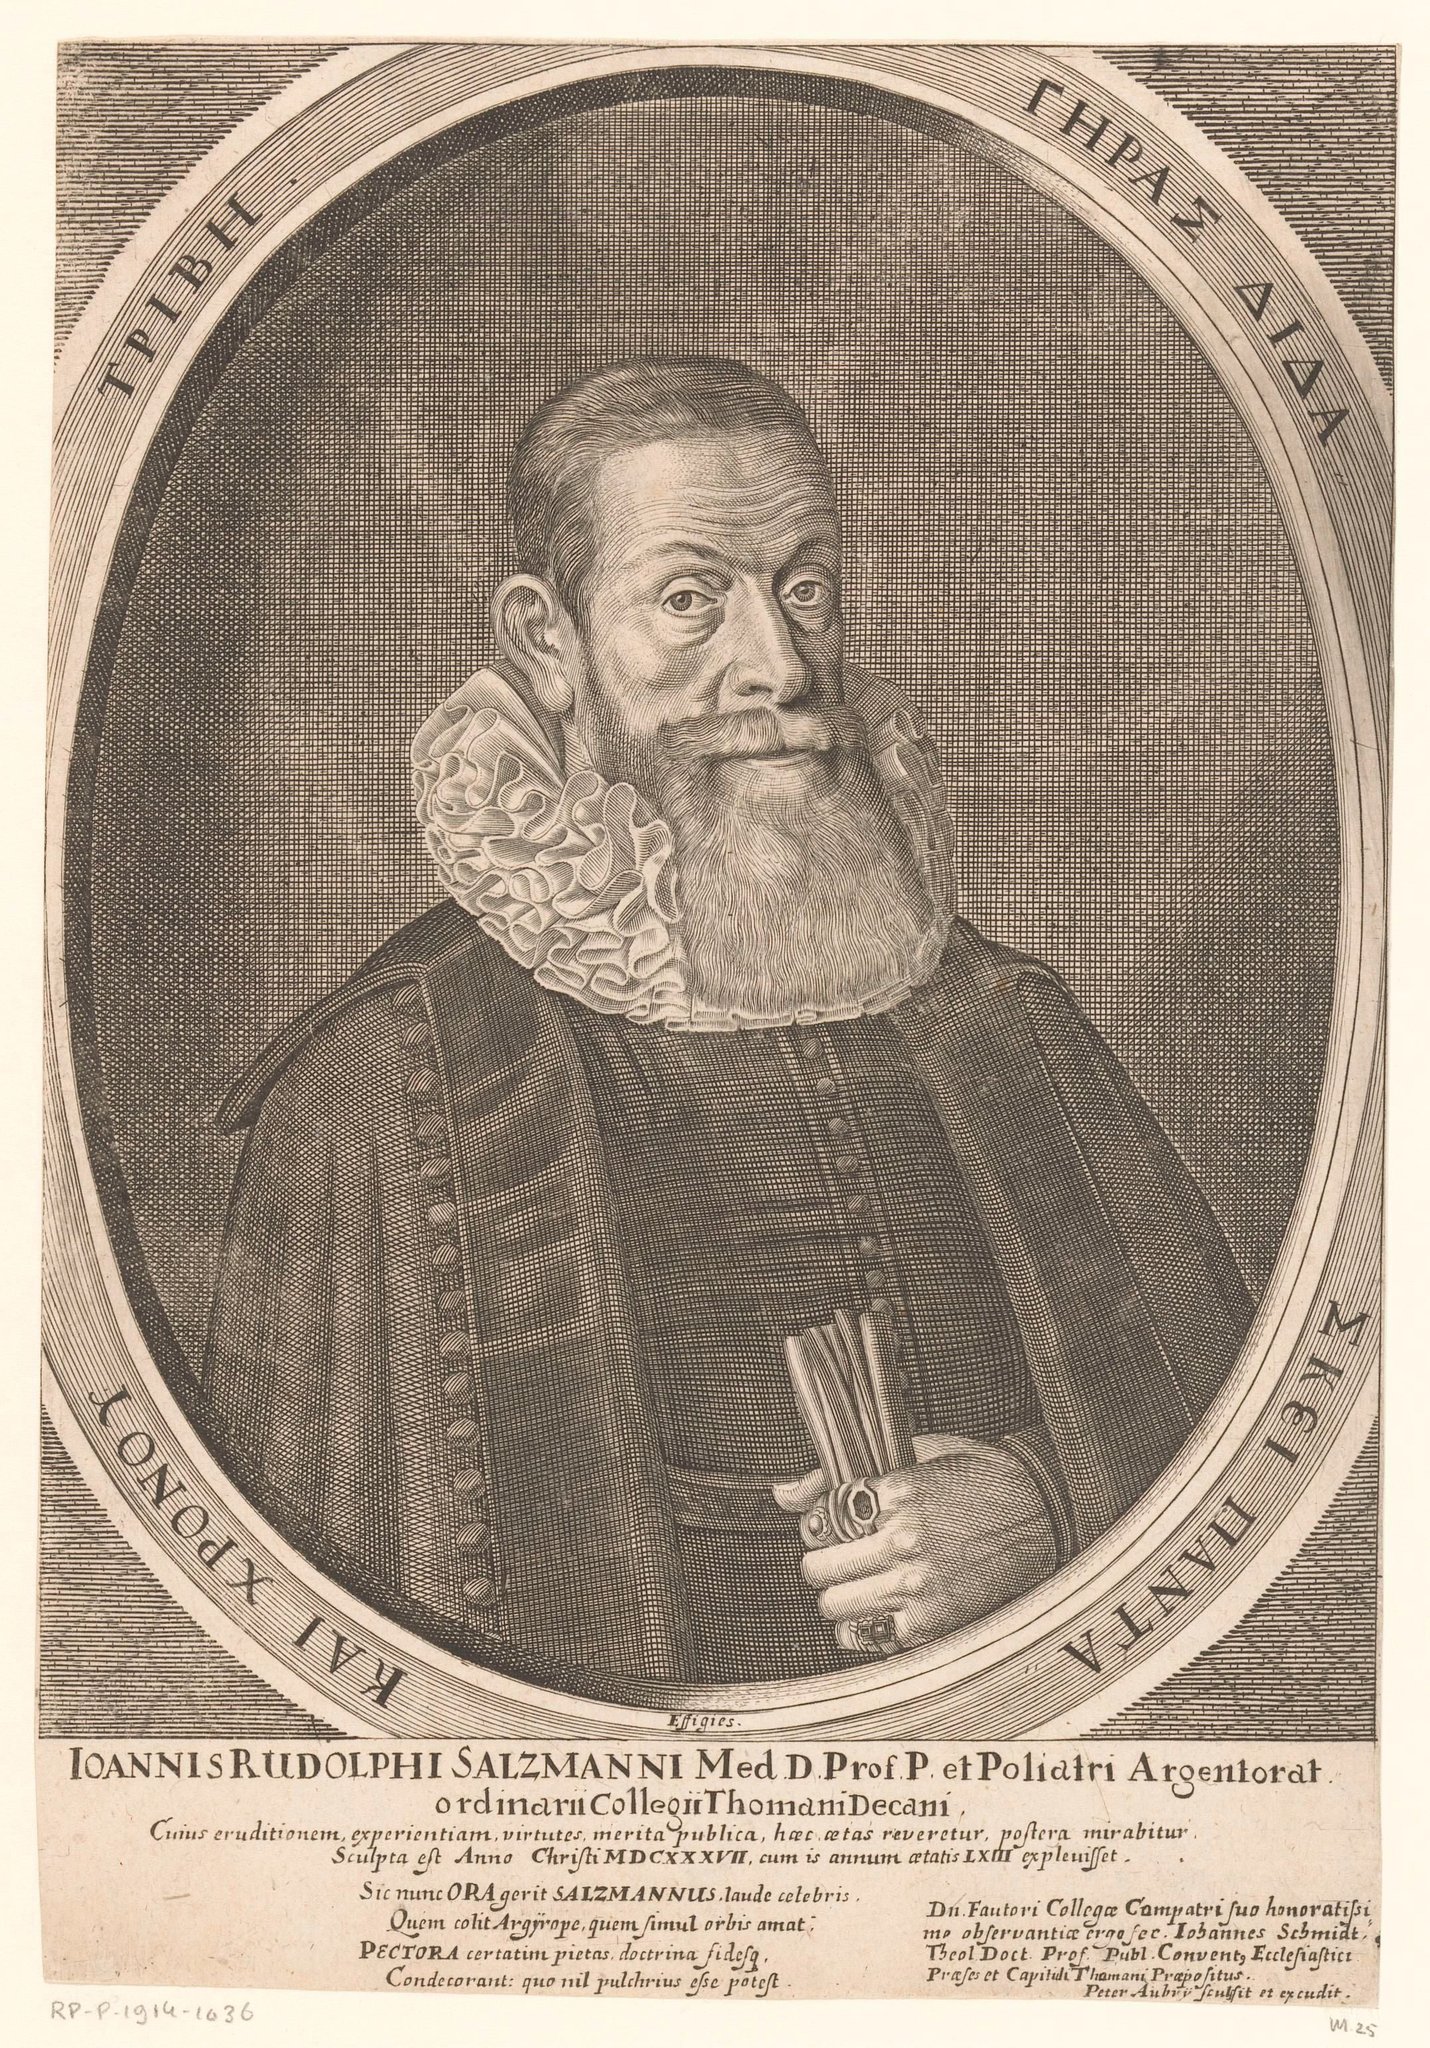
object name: print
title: Ioanni Rudolphi Salzmanni (...)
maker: peter aubry (iii)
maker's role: print maker, publisher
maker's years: 1610-1686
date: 1637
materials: paper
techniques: engraving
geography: straatsburg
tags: johann rudolph saltzmann, historical persons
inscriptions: collector's mark: Lugt 2228